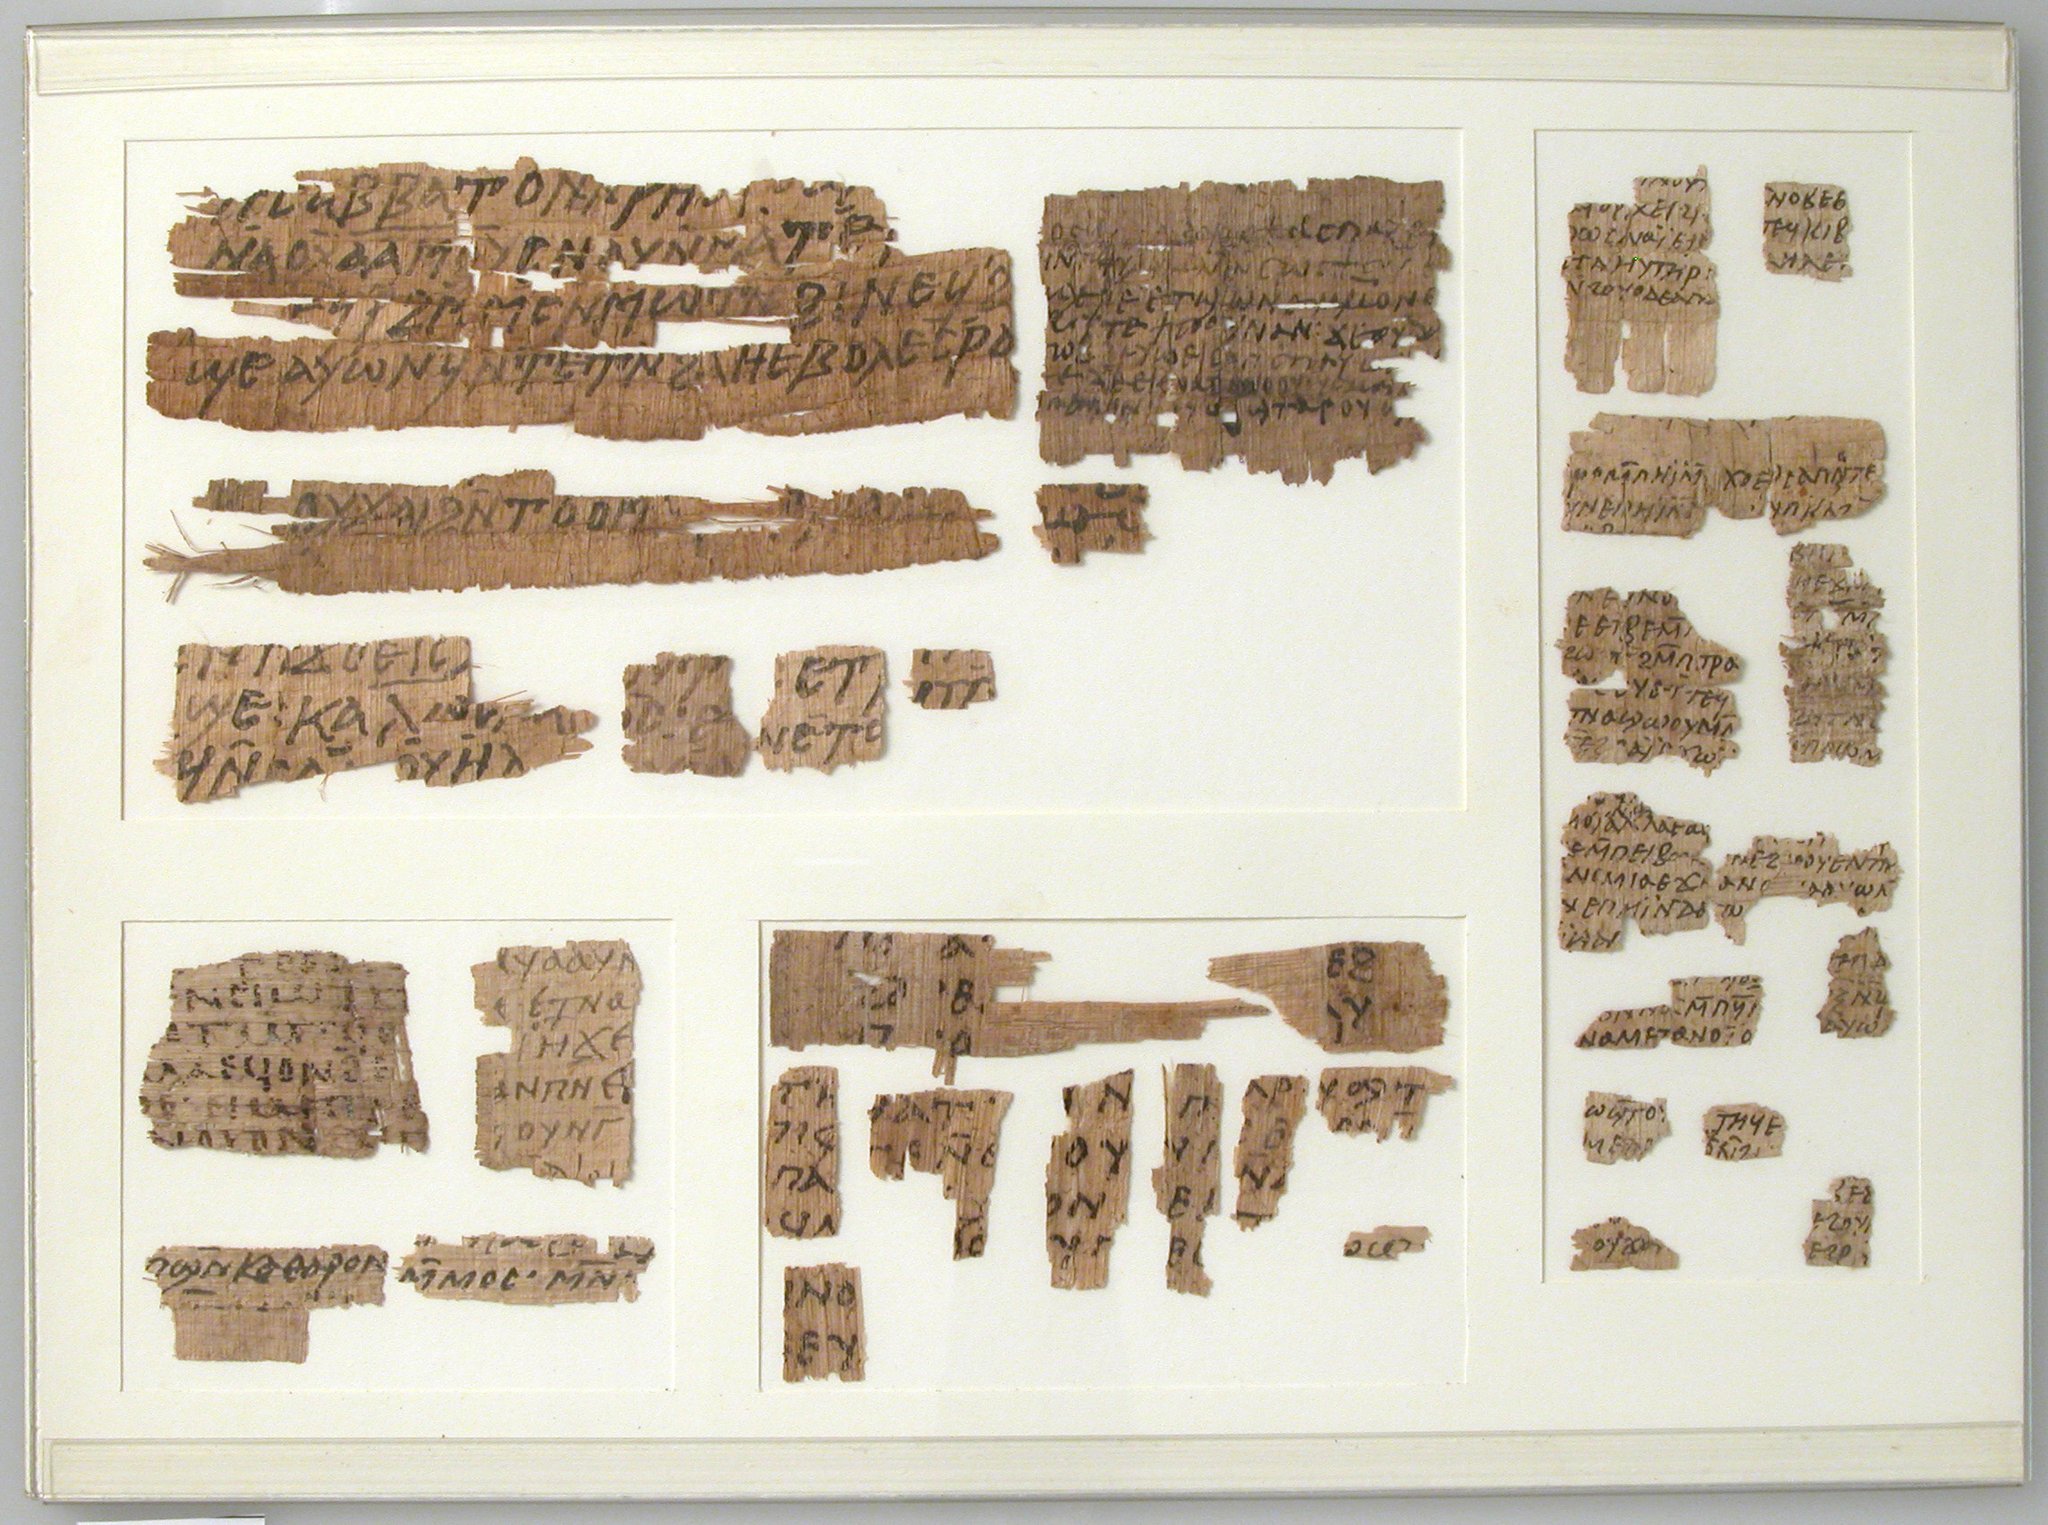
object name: fragment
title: Papyri Fragments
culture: coptic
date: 601-700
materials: ink, papyrus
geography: egypt